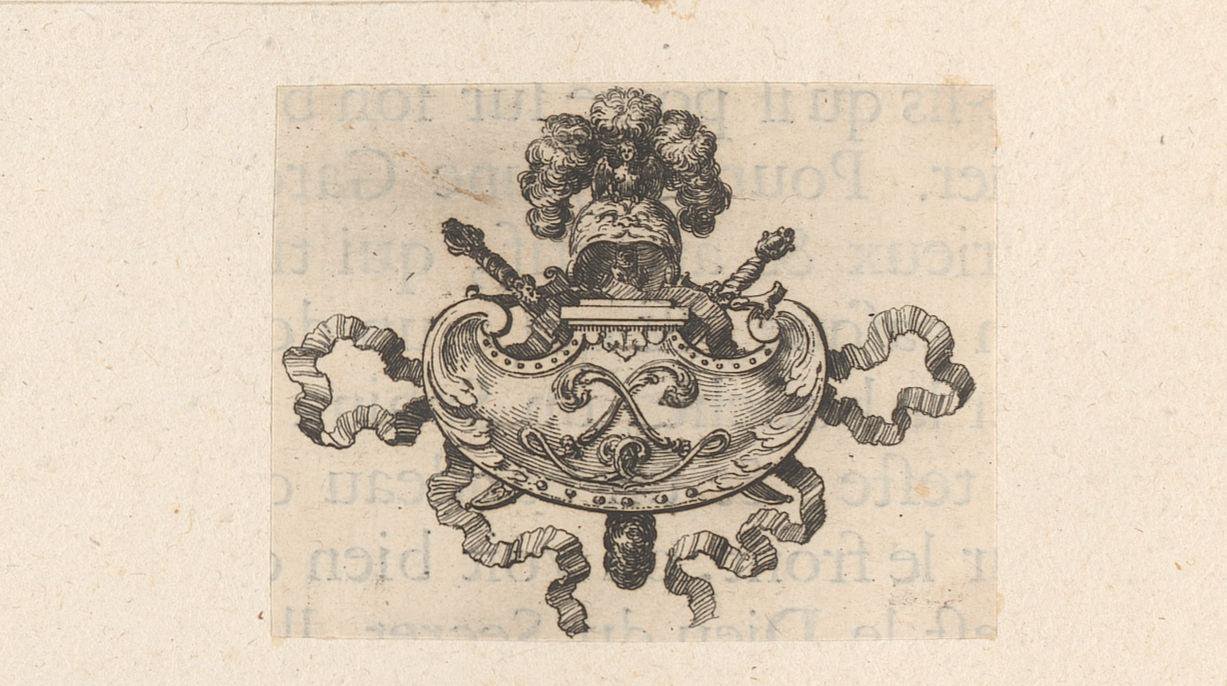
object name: print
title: Cul-de-lampe met de initialen van de koning op een schild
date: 1687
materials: paper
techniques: etching, letterpress printing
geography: versailles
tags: protective weapons: shield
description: Prent uit: Rainssant, Pierre. Explication des tableaux de la galerie de Versailles (...). Versailles: François Muguet, 1687.